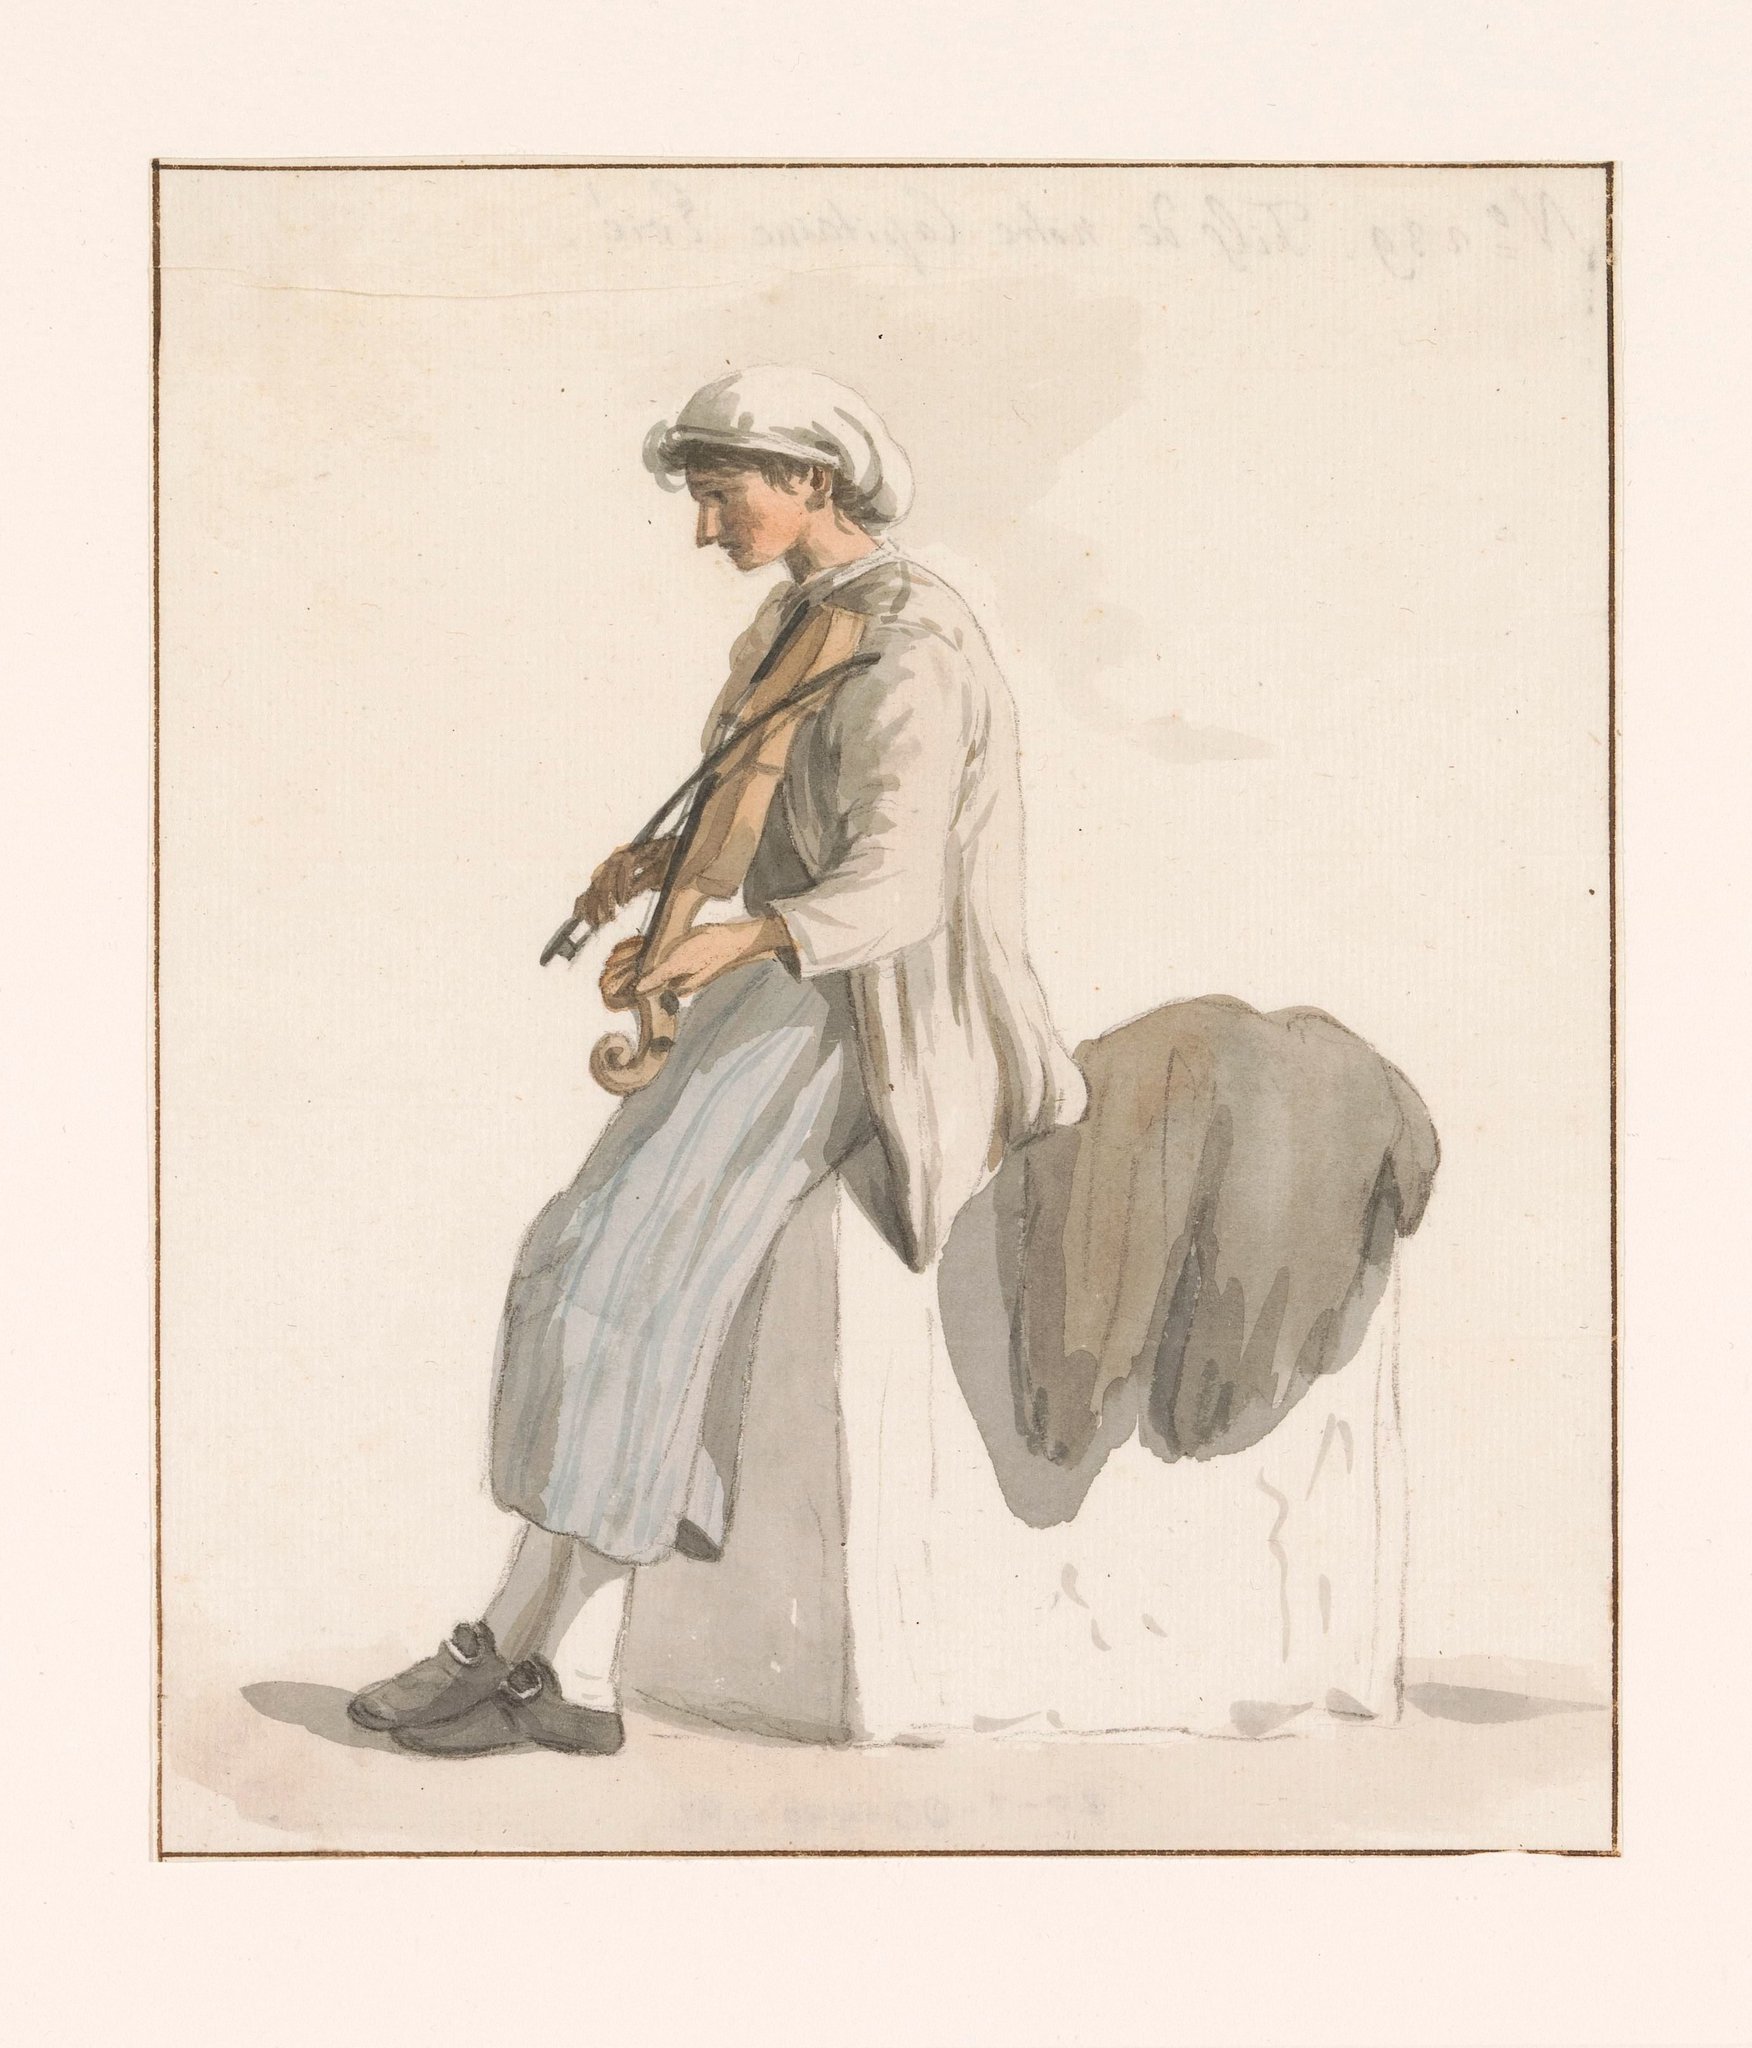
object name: watercolor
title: Voyage en Italie, en Sicile et à Malte - 1778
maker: louis ducros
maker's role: draughtsman, print maker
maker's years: 1748-1810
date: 1778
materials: chalk, paper, watercolor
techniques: brush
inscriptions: inscription: ‘No 239 Fils de notre Capitaine Erié’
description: Tekening uit het album 'Voyage en Italie, en Sicile et à Malte', 1778.